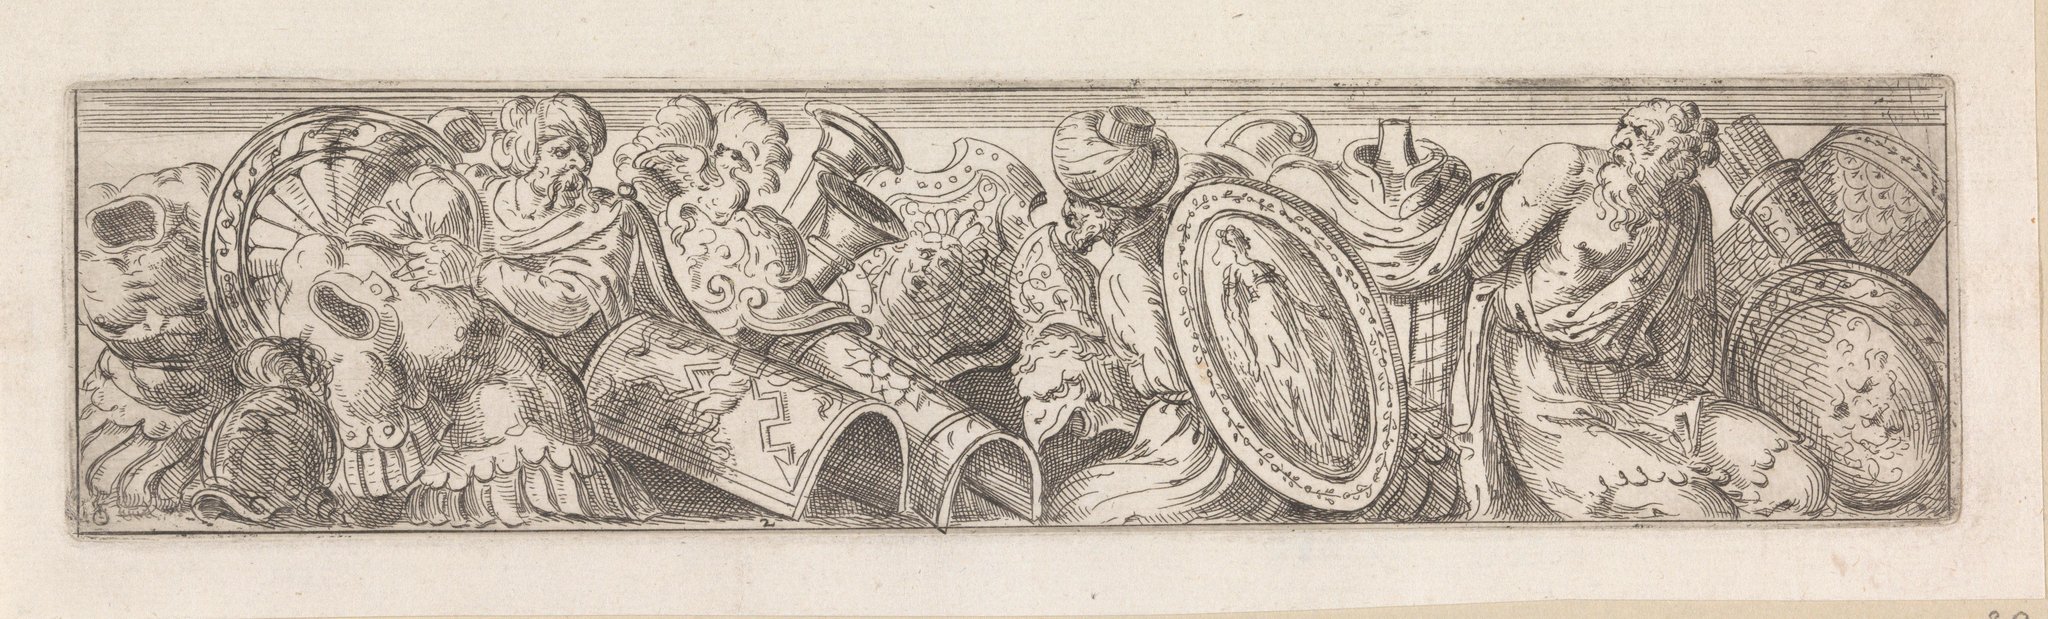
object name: print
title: Fries met wapens, een geboeide man (krijgsgevangene of slaafgemaakte) en twee oosterse figuren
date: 1583-1638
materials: paper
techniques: etching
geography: italy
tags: sitting figure, weapons, slavery; serfs and enslaved persons, prisoner of war (after the battle)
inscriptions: collector's mark: Lugt 240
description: Prent uit een reeks van vijf prenten, plus titelprent.